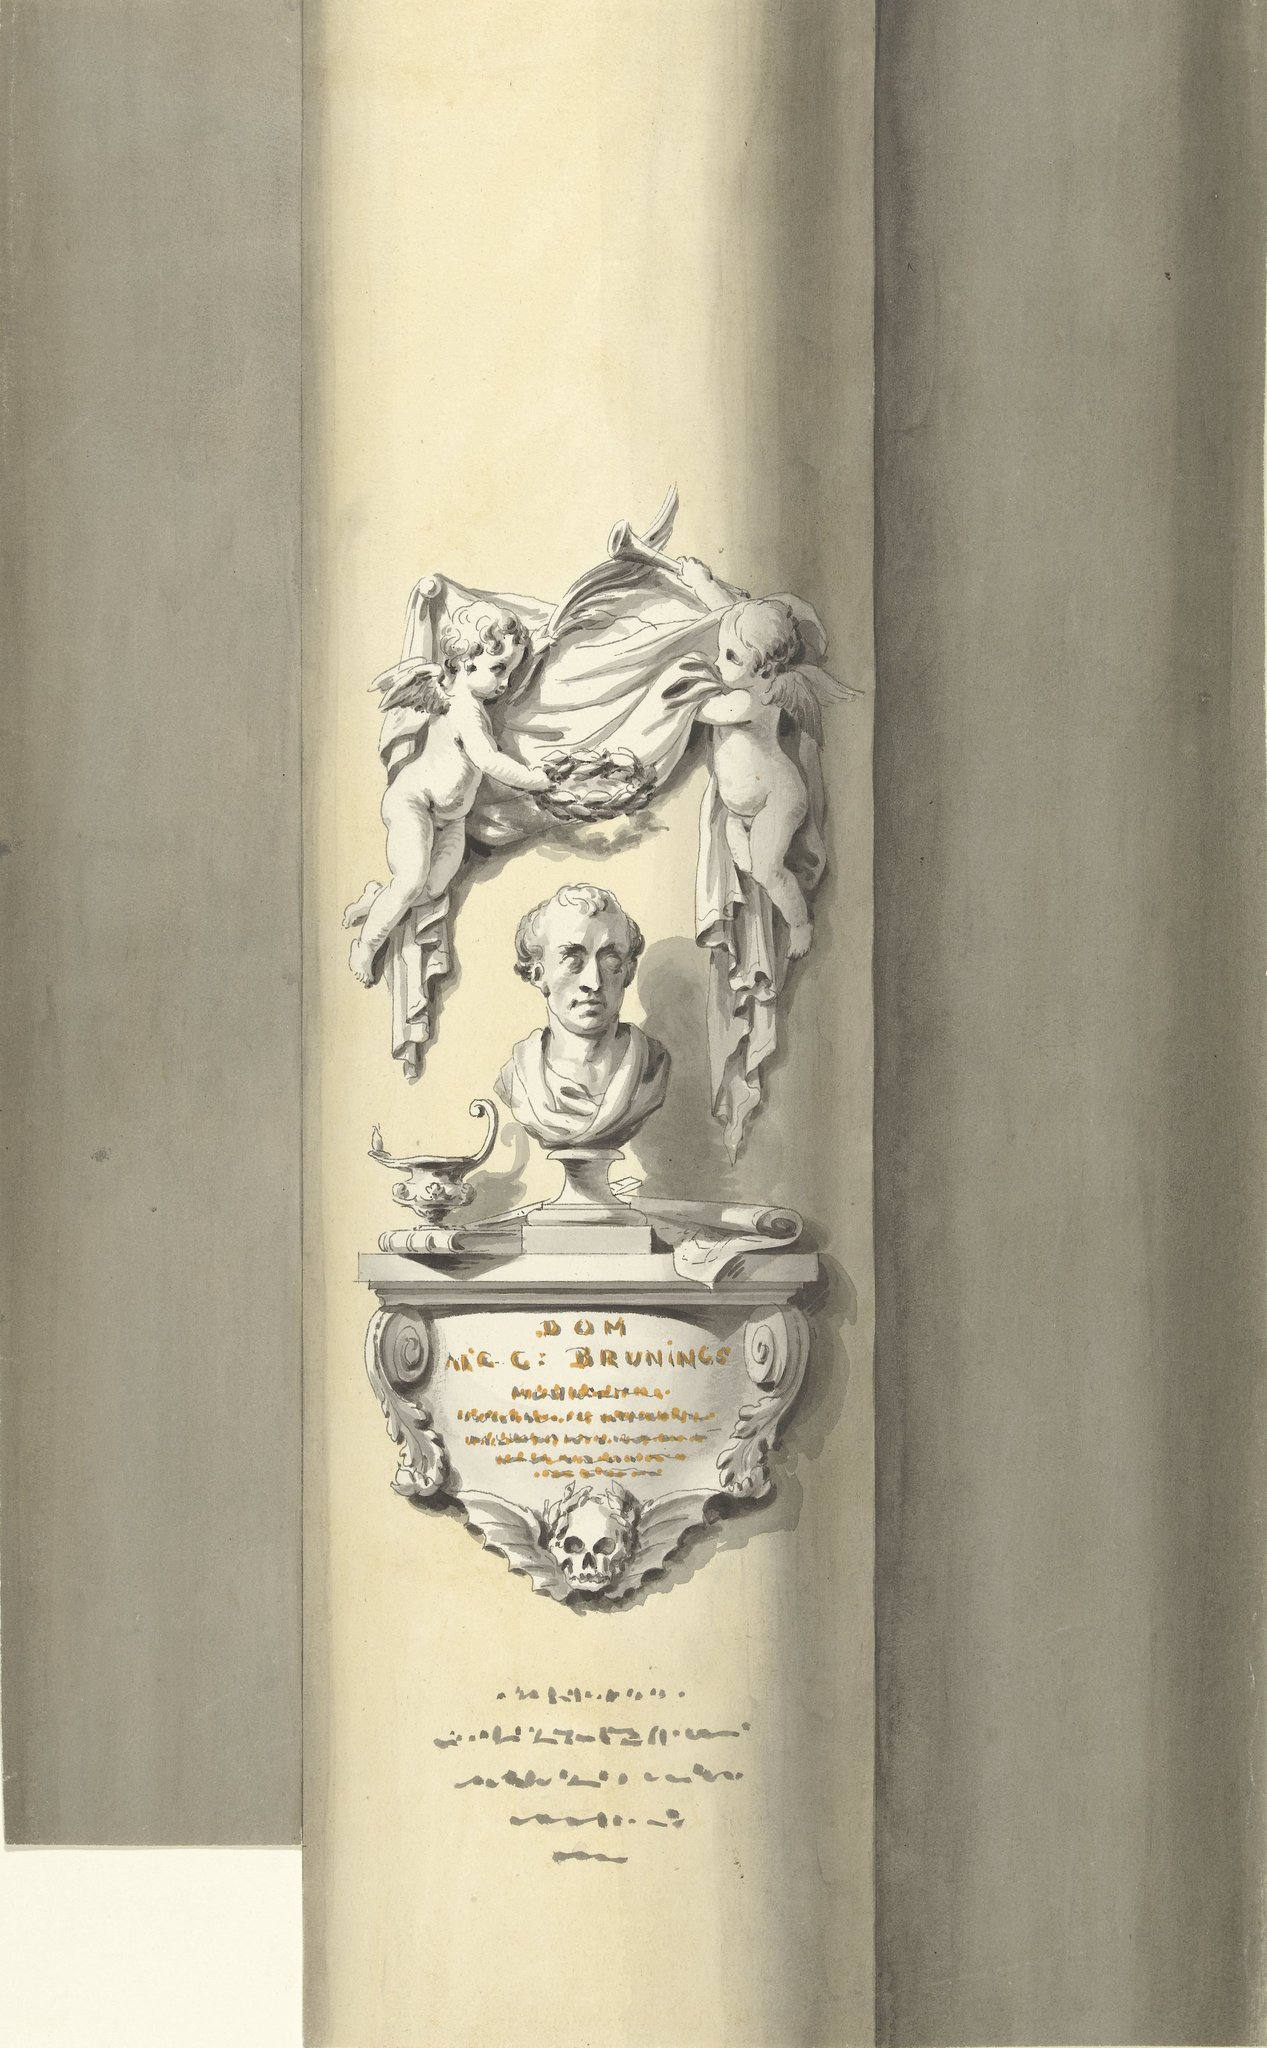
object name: drawing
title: Ontwerp voor een monument voor C. Brunings: een borstbeeld met putti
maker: bartholomeus ziesenis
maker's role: draughtsman, sculptor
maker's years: 1768-1820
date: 1806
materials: paper, watercolor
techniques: brush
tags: christiaan l. brunings (i), historical persons, piece of sculpture, reproduction of a piece of sculpture, other memorial structures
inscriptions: inscription: ‘No.3 / Ziesenis. / architect / 12 junij 1806 / inv: et del. / [potlood:] f 12000.-’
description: De heer M. Zisenis (E: dr.zisenis@zifec.de) gaf aan dat het hier om de vervaardiger Bartholomeus Ziesenis gaat. Na goedkeuring van Robert-Jan te Rijdt record aangepast. (2012-02-13)